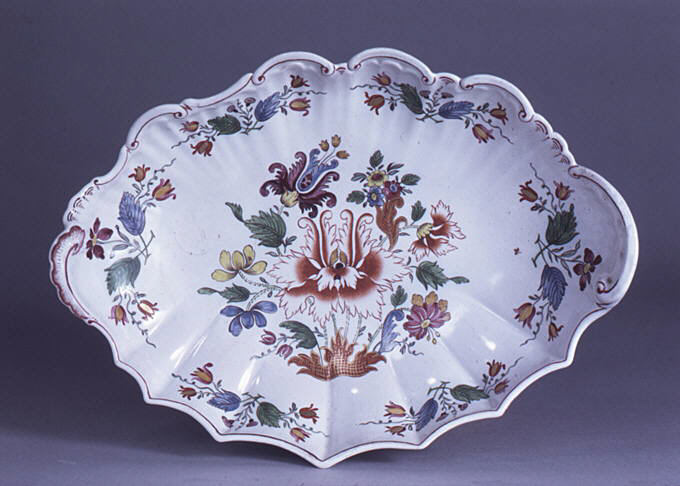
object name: dish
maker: doccia porcelain manufactory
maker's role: manufactory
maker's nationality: italian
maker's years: 1737-1896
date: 1760-1770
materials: hard paste porcelain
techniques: glazing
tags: flowers